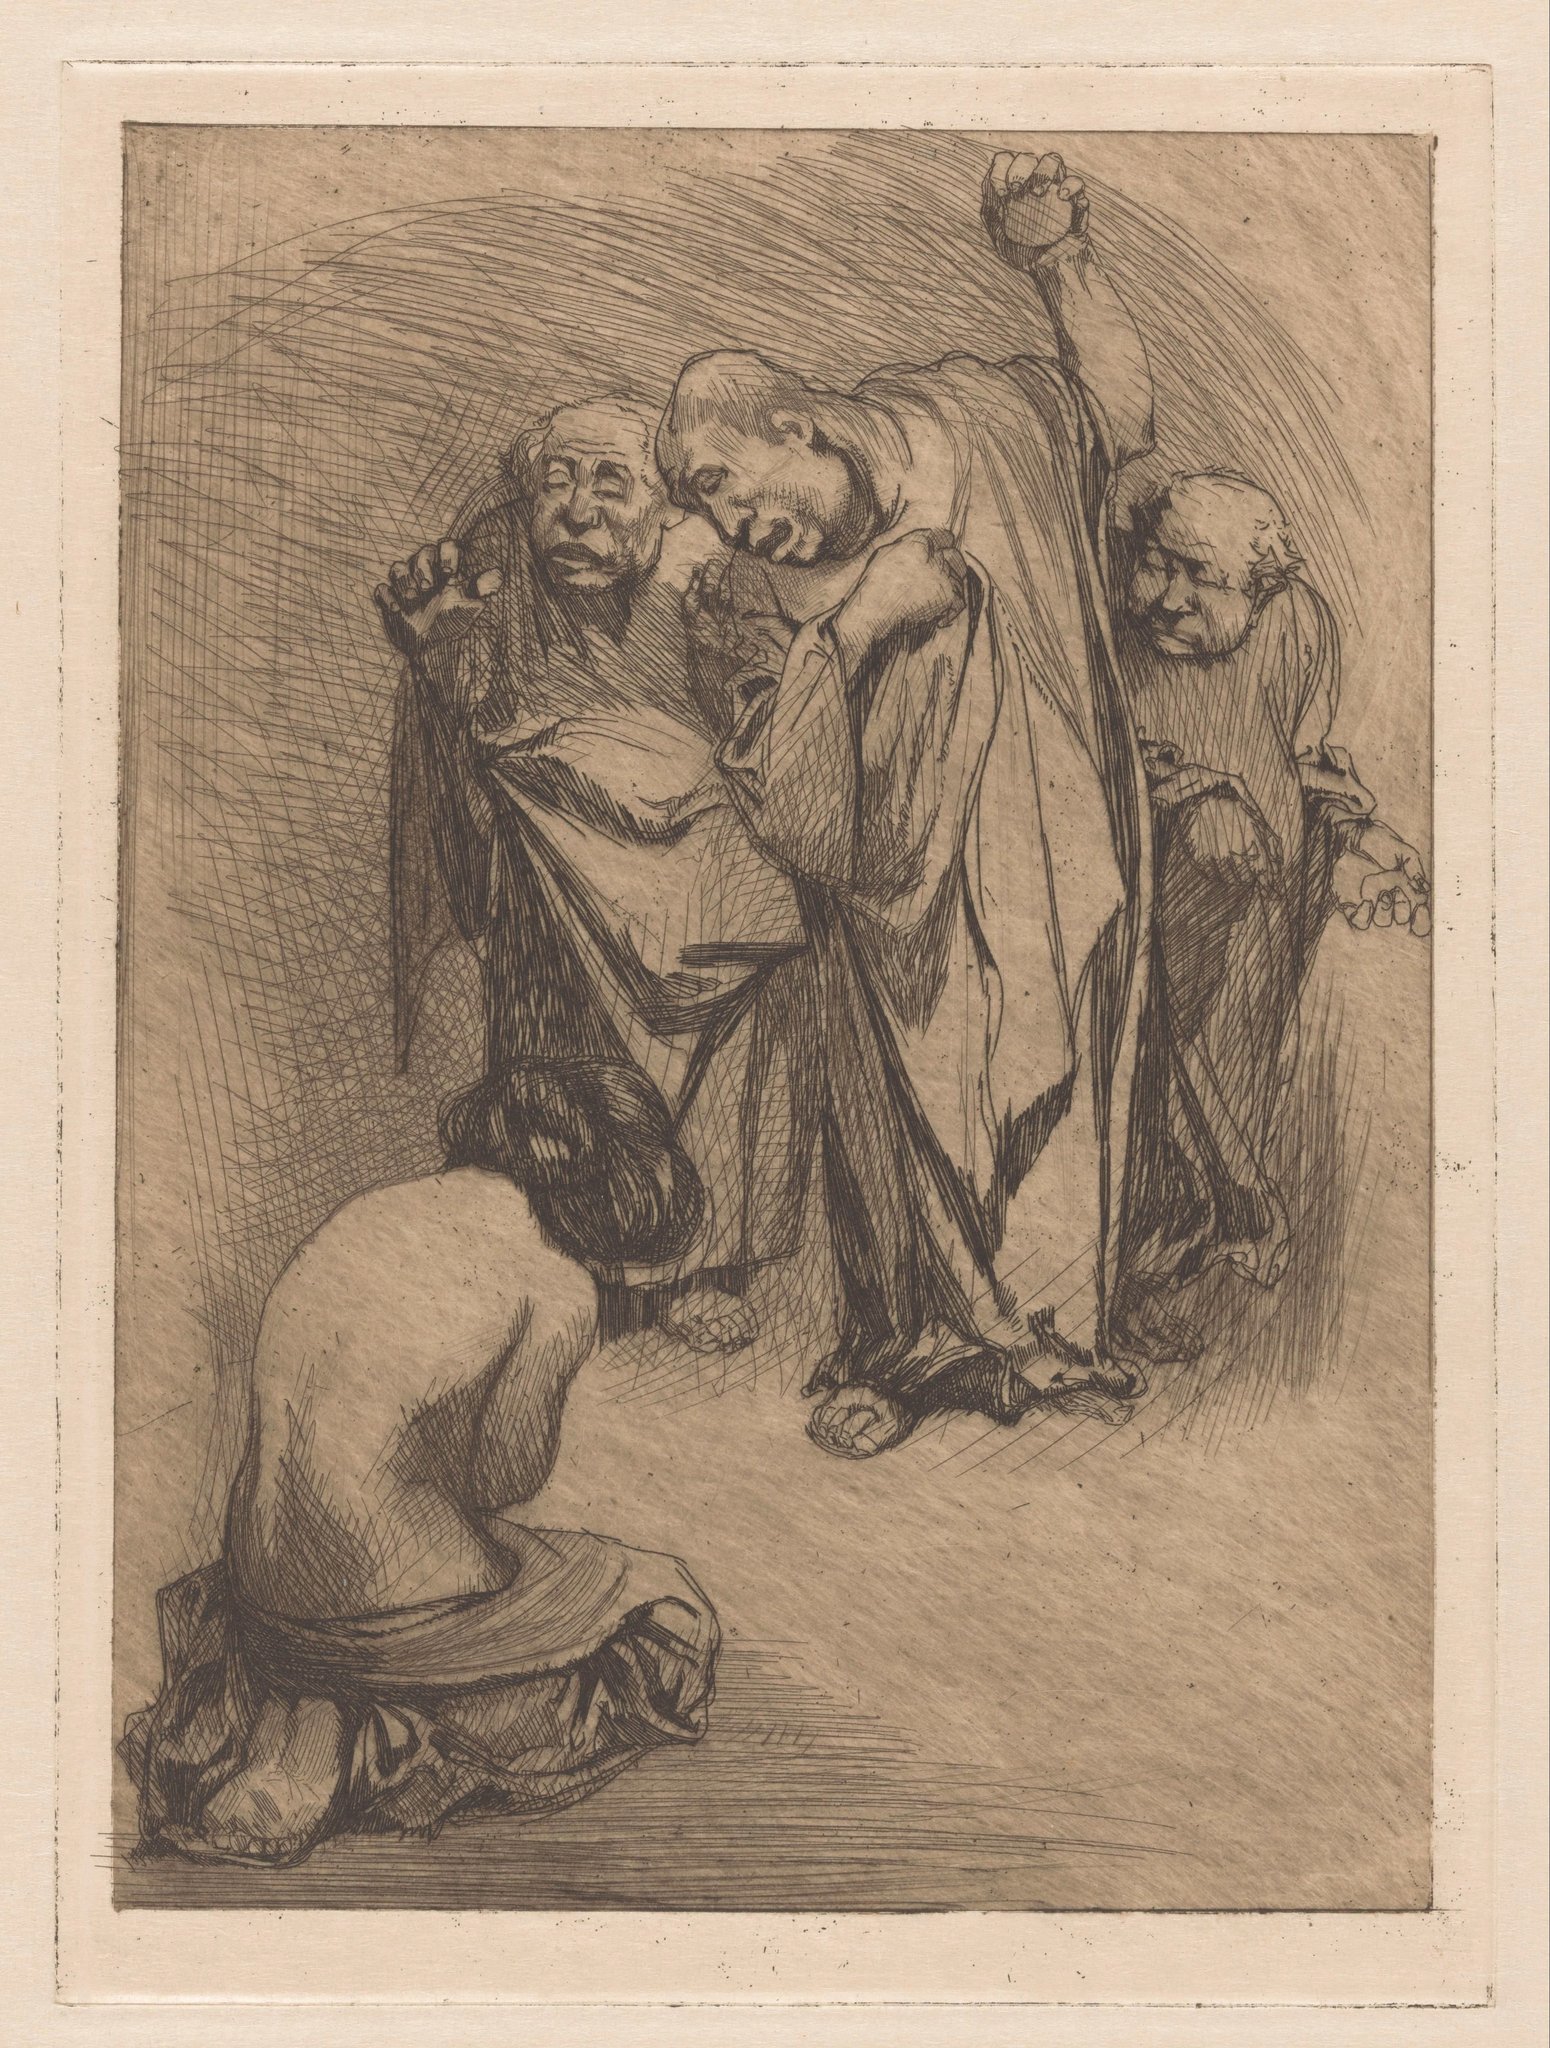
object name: print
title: Steniging van een vrouw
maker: johannes josephus aarts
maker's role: draughtsman, print maker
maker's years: 1871-1934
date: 1881-1934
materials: paper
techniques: etching, intaglio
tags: violent death by stoning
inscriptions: collector's mark: Lugt 2228, collector's mark: Lugt 2760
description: Links op de voorgrond knielt een vrouw met ontbloot bovenlijf. Tegenover haar staan drie mannen, waarvan de middelste zijn linkerarm opheft. In zijn hand bevindt zich een kei.